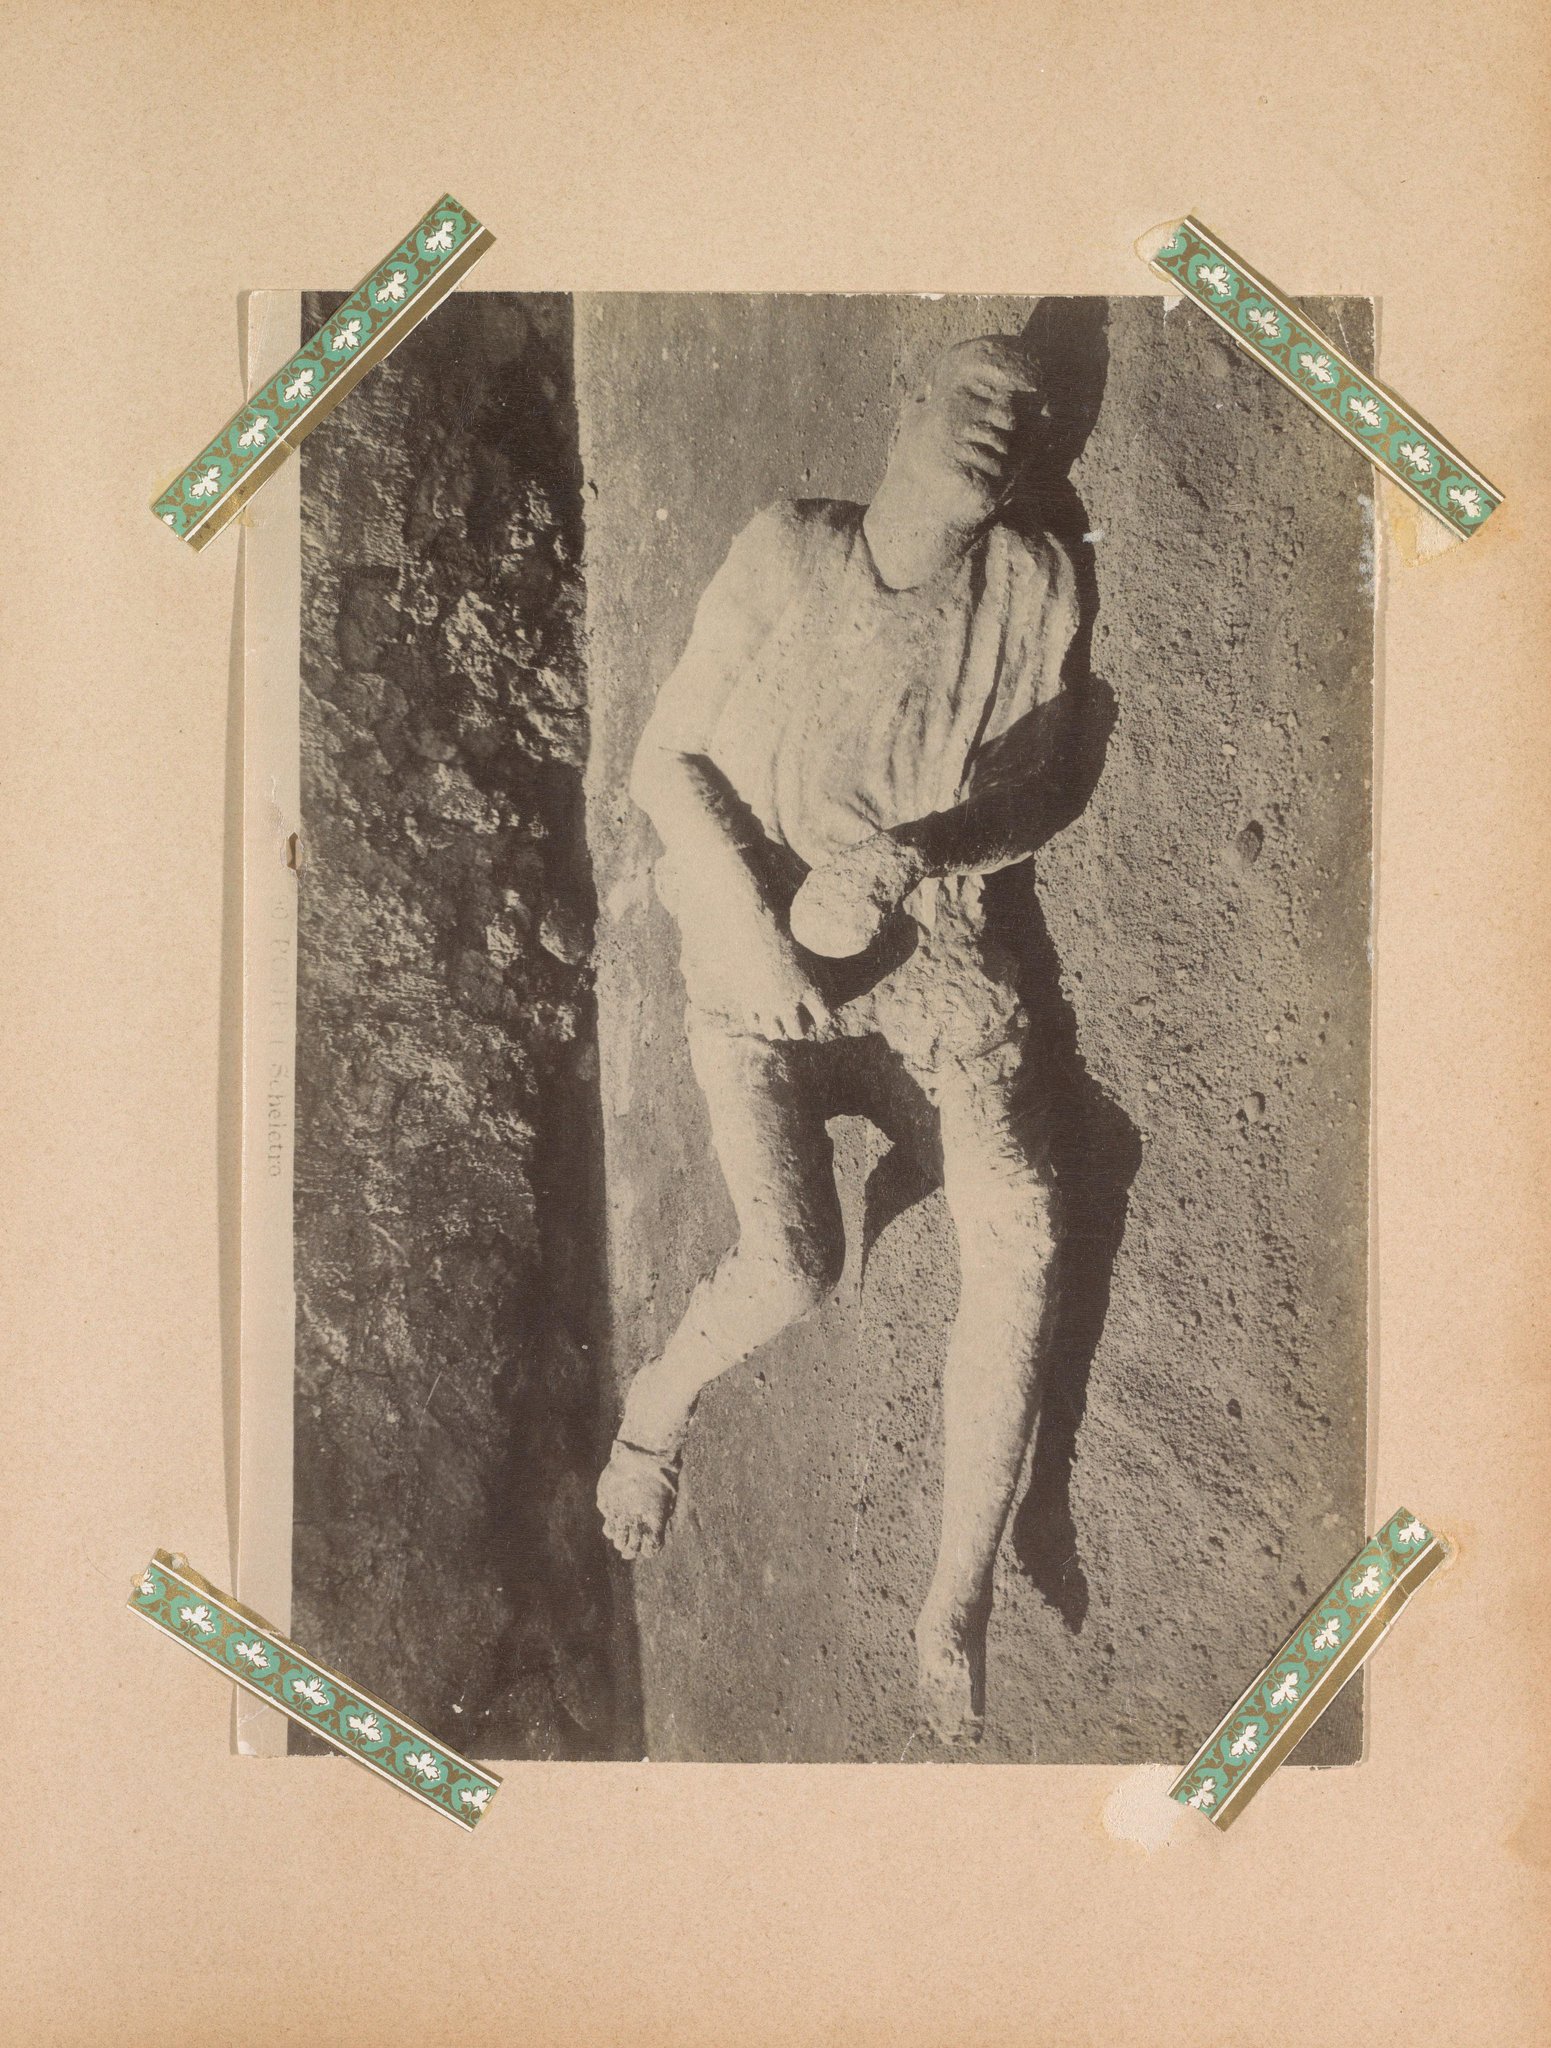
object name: album leaf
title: Afgietsel van een slachtoffer van de vulkaanuitbarsting in Pompeï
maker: Anonymous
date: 1870-1900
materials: paper, photographic support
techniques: albumen print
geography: pompeii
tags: the corpse, eruption (of volcano), pompeii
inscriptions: negative number: ‘[...]90’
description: Onderdeel van Reisalbum met foto's van bezienswaardigheden in Italië en Zuid-Frankrijk.